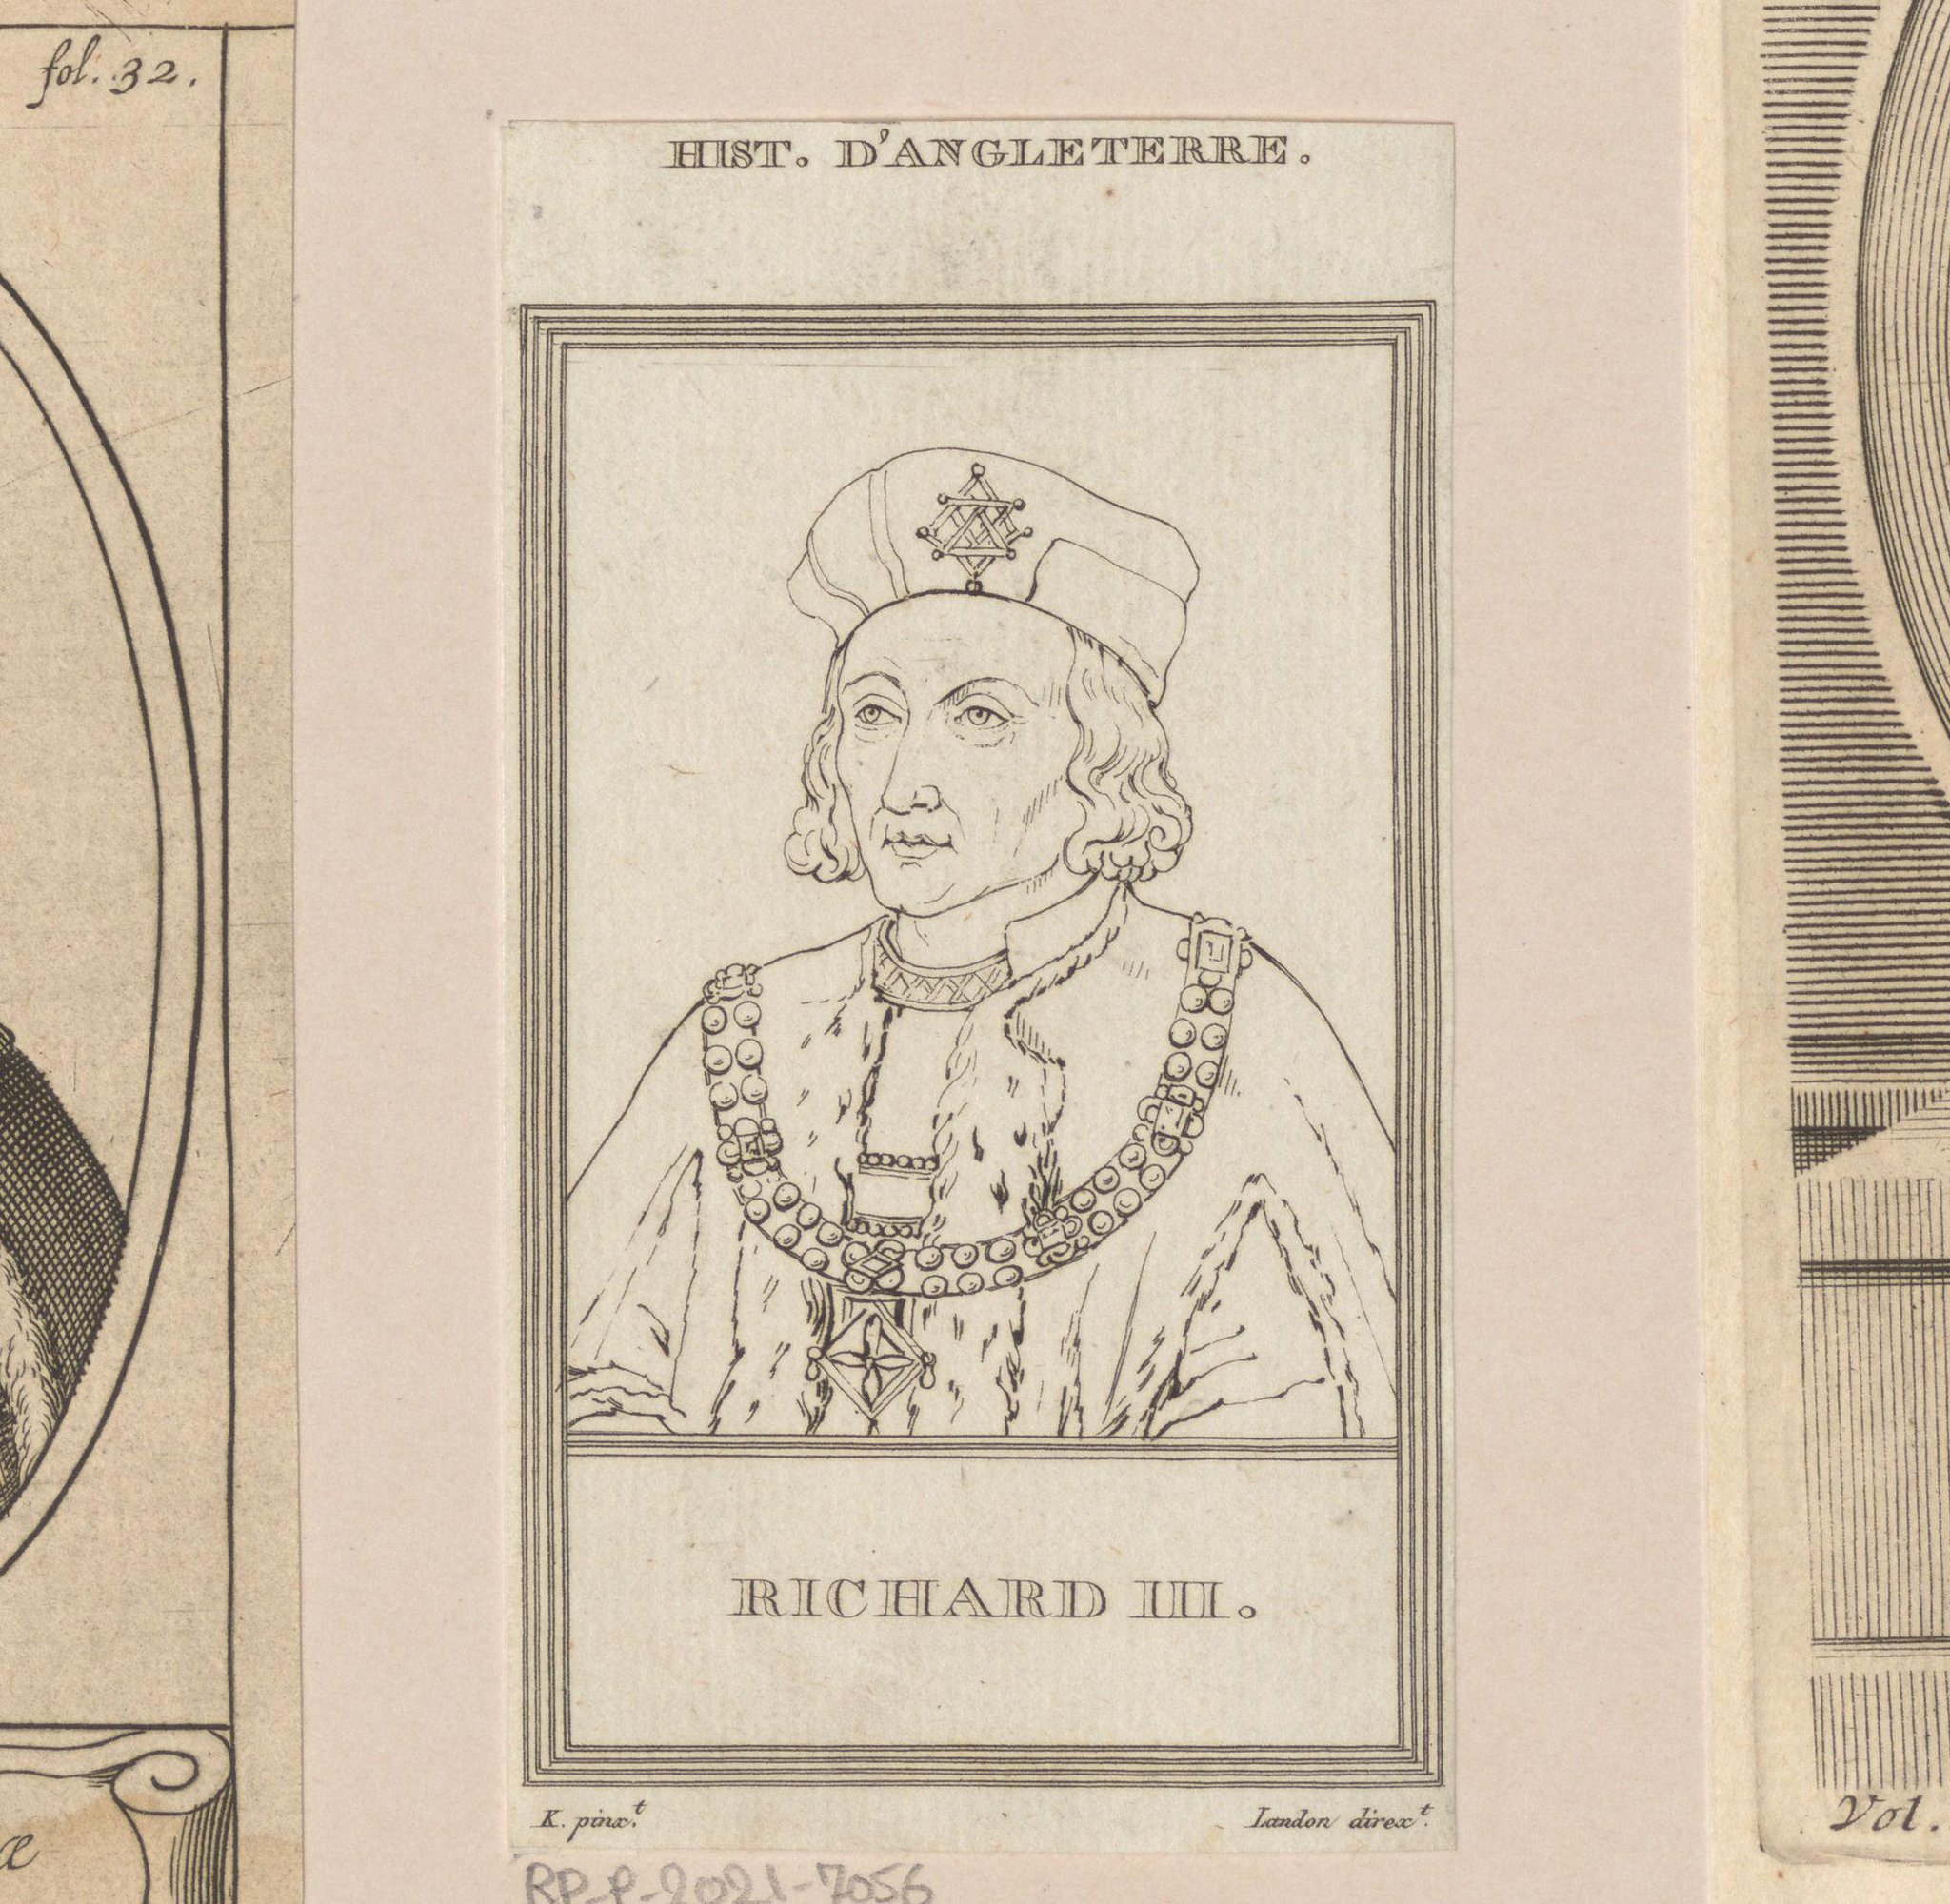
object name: print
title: Portret van Richard III, koning van Engeland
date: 1804-1808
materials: paper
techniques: etching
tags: historical persons, king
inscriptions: signature: ‘K.’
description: Prent mogelijk uit: Galerie historique des hommes les plus célèbres (...). Parijs: Charles Paul Landon, 1808, dl. 10. Of uit een eerdere publicatie (1804).